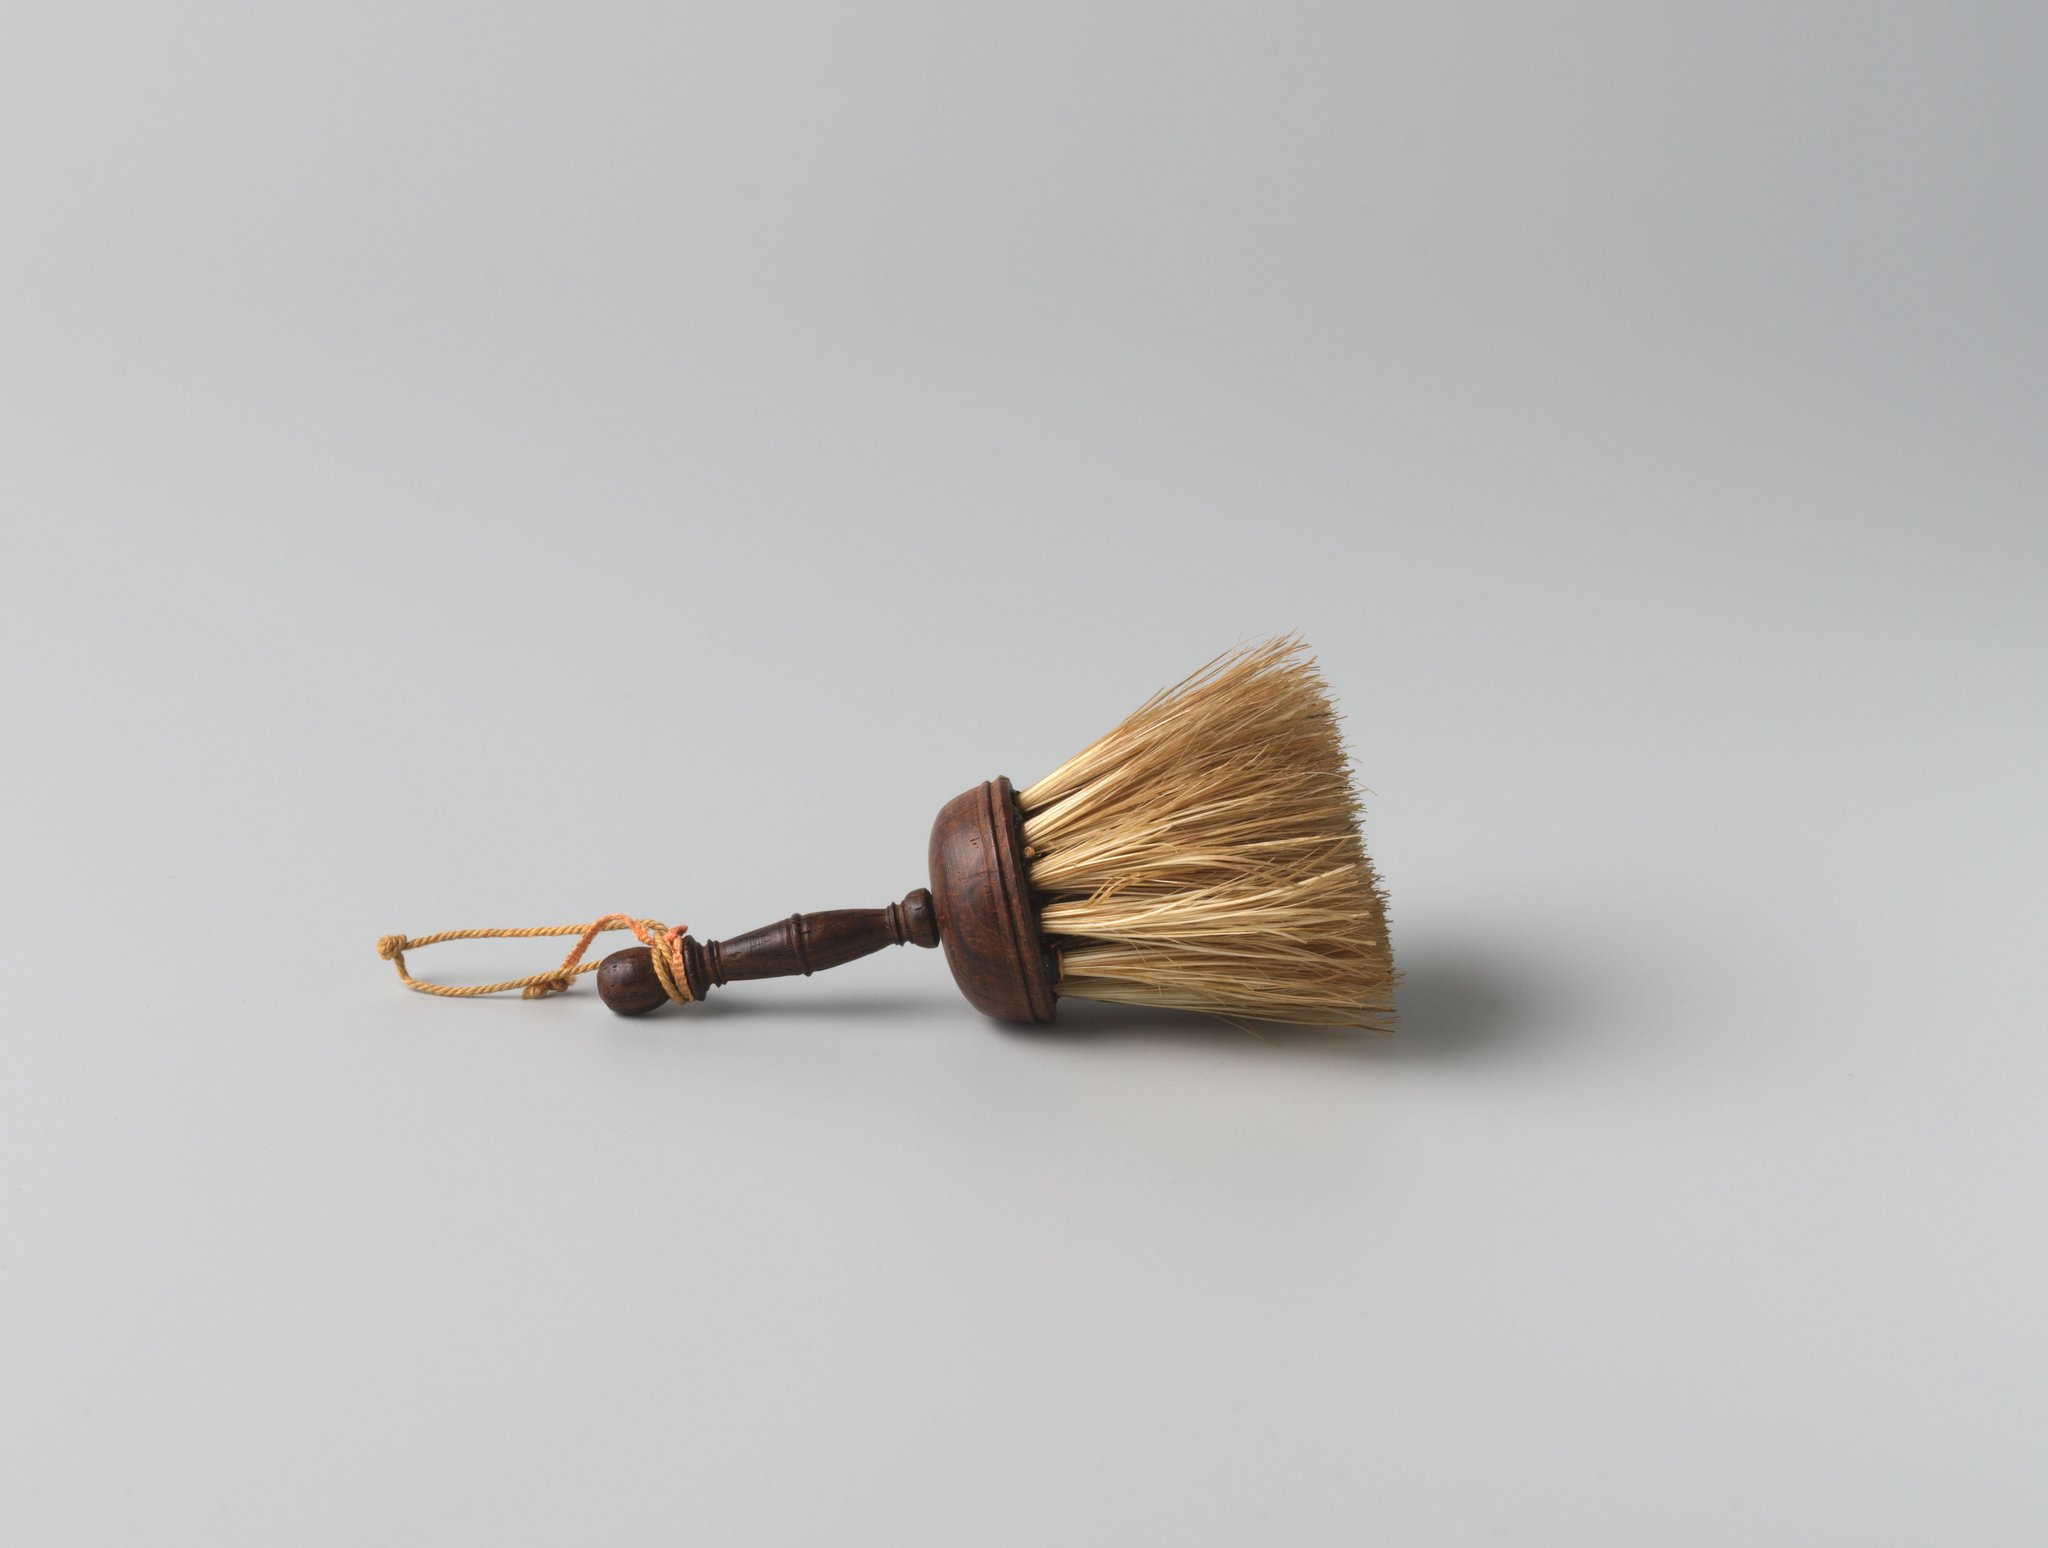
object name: brush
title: Borstel van palissanderhout en varkenshaar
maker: Anonymous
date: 1676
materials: wood, silk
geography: amsterdam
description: Borstel van palissanderhout en varkenshaar. De borstel heeft een brede, ronde geprofileerde kop en korte gedraaide steel met geprofileerde versieringen en knop, waaraan resten van een roze zijden lint.